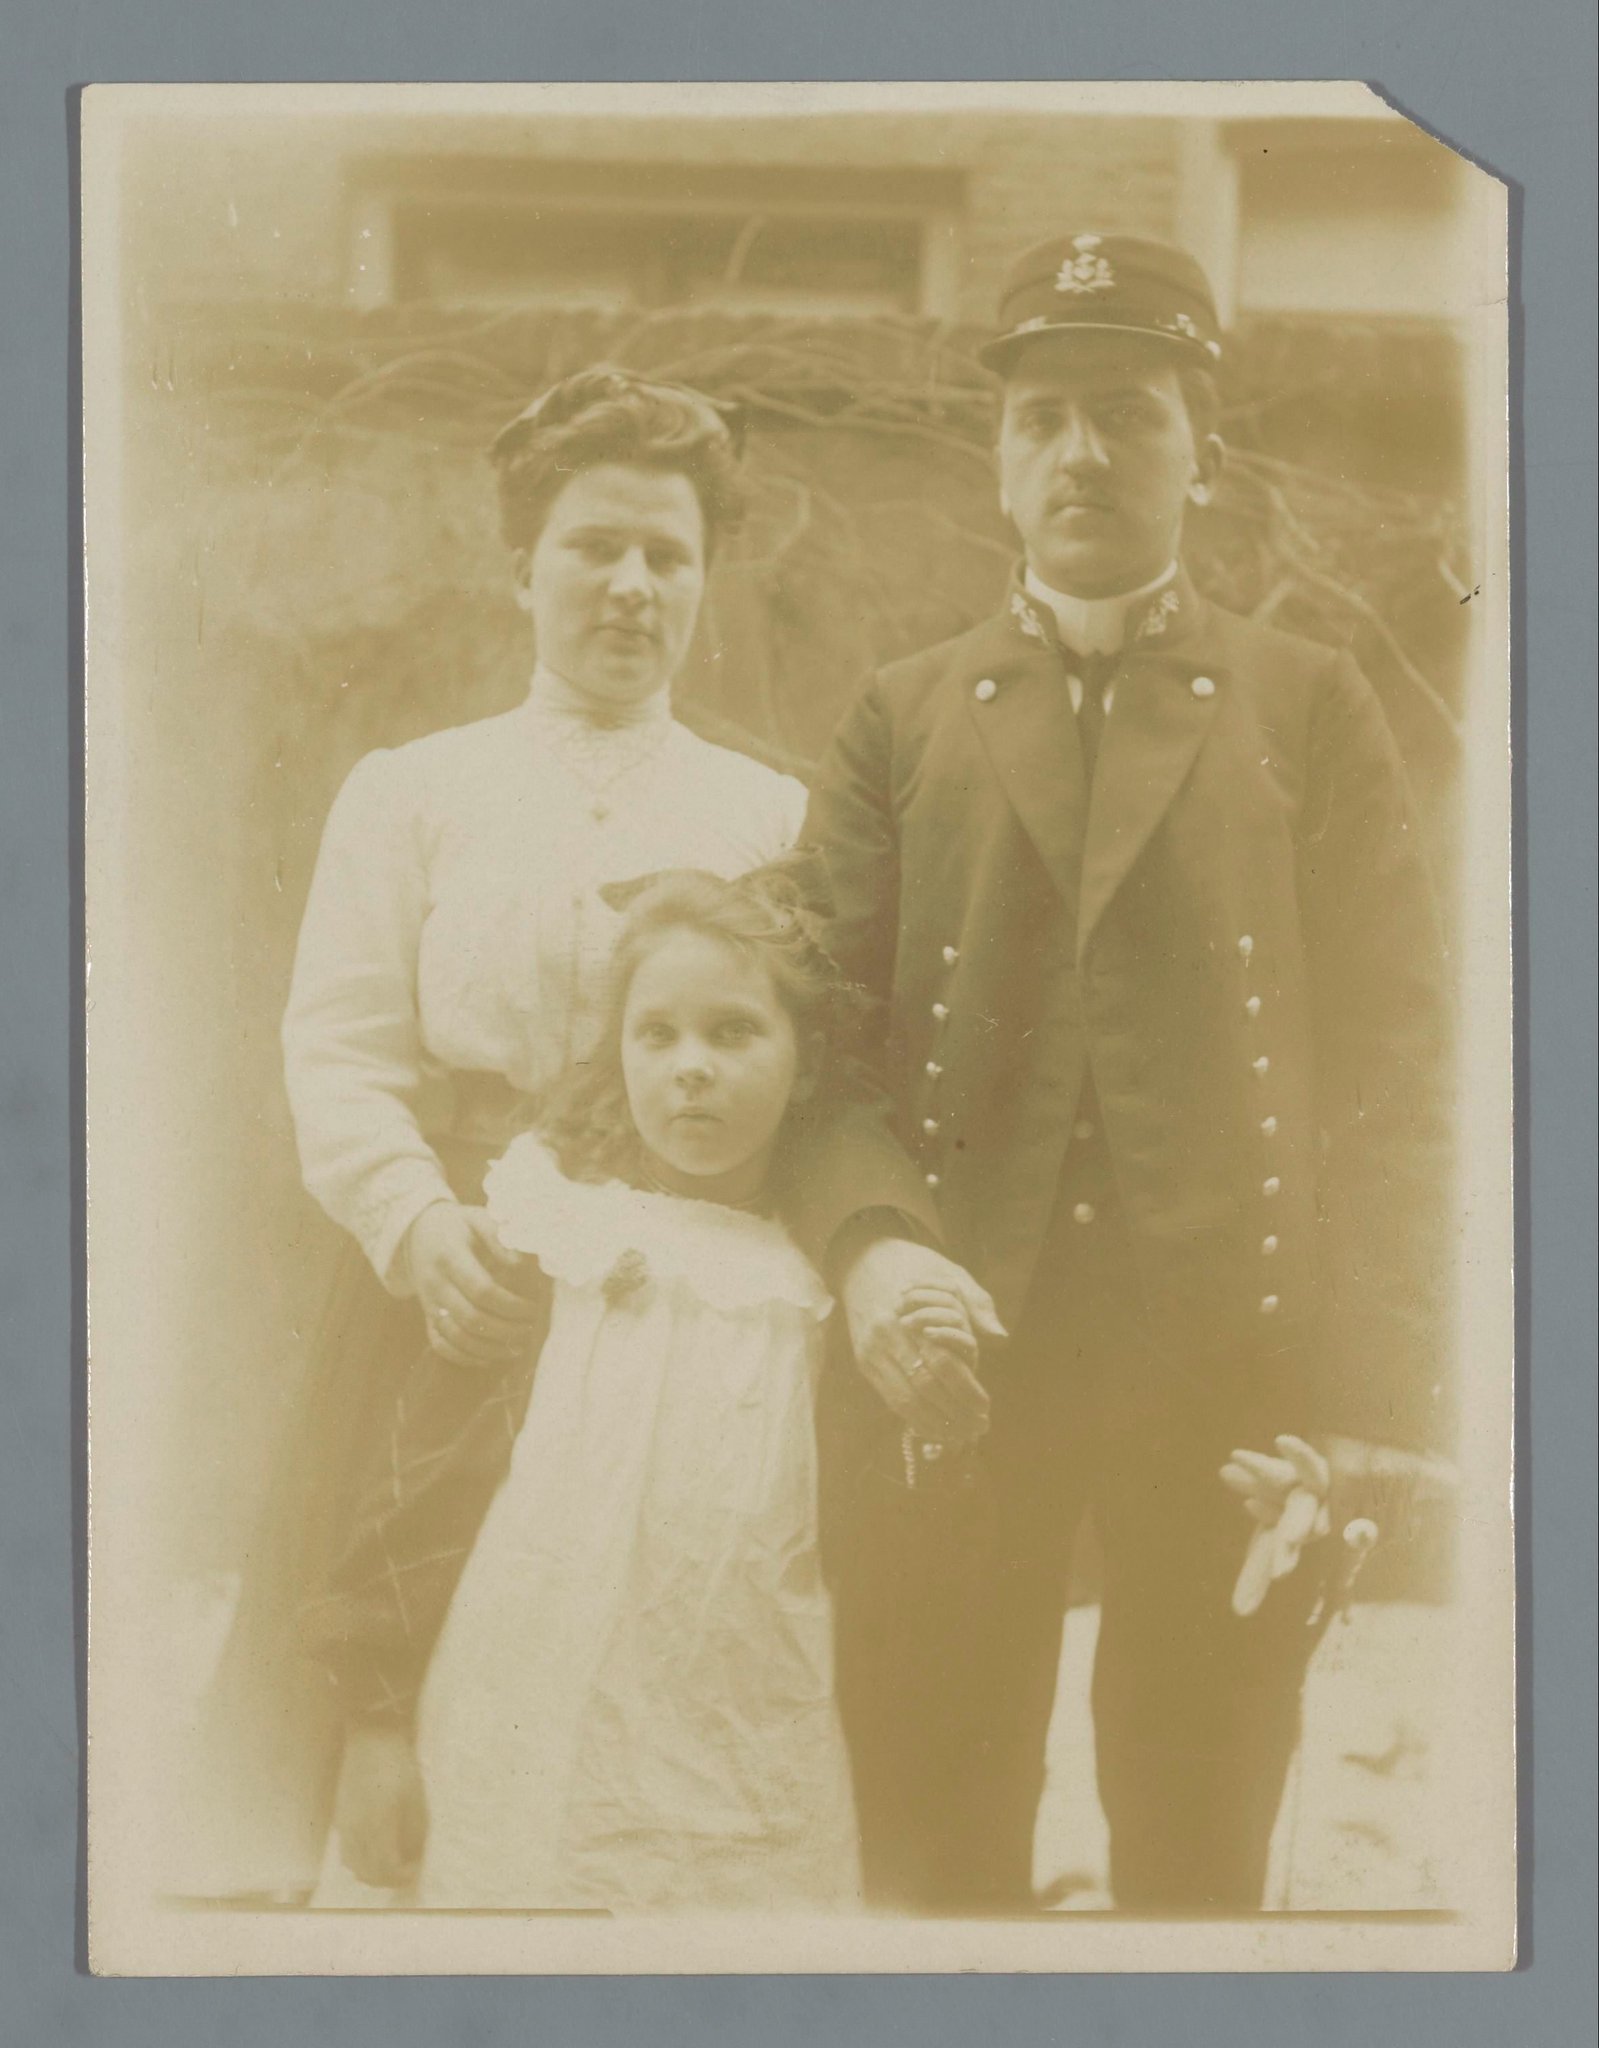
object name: photograph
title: Portret van een echtpaar met een kind in een tuin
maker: Anonymous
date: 1900-1915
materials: photographic support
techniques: gelatin silver print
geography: netherlands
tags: parents with their children